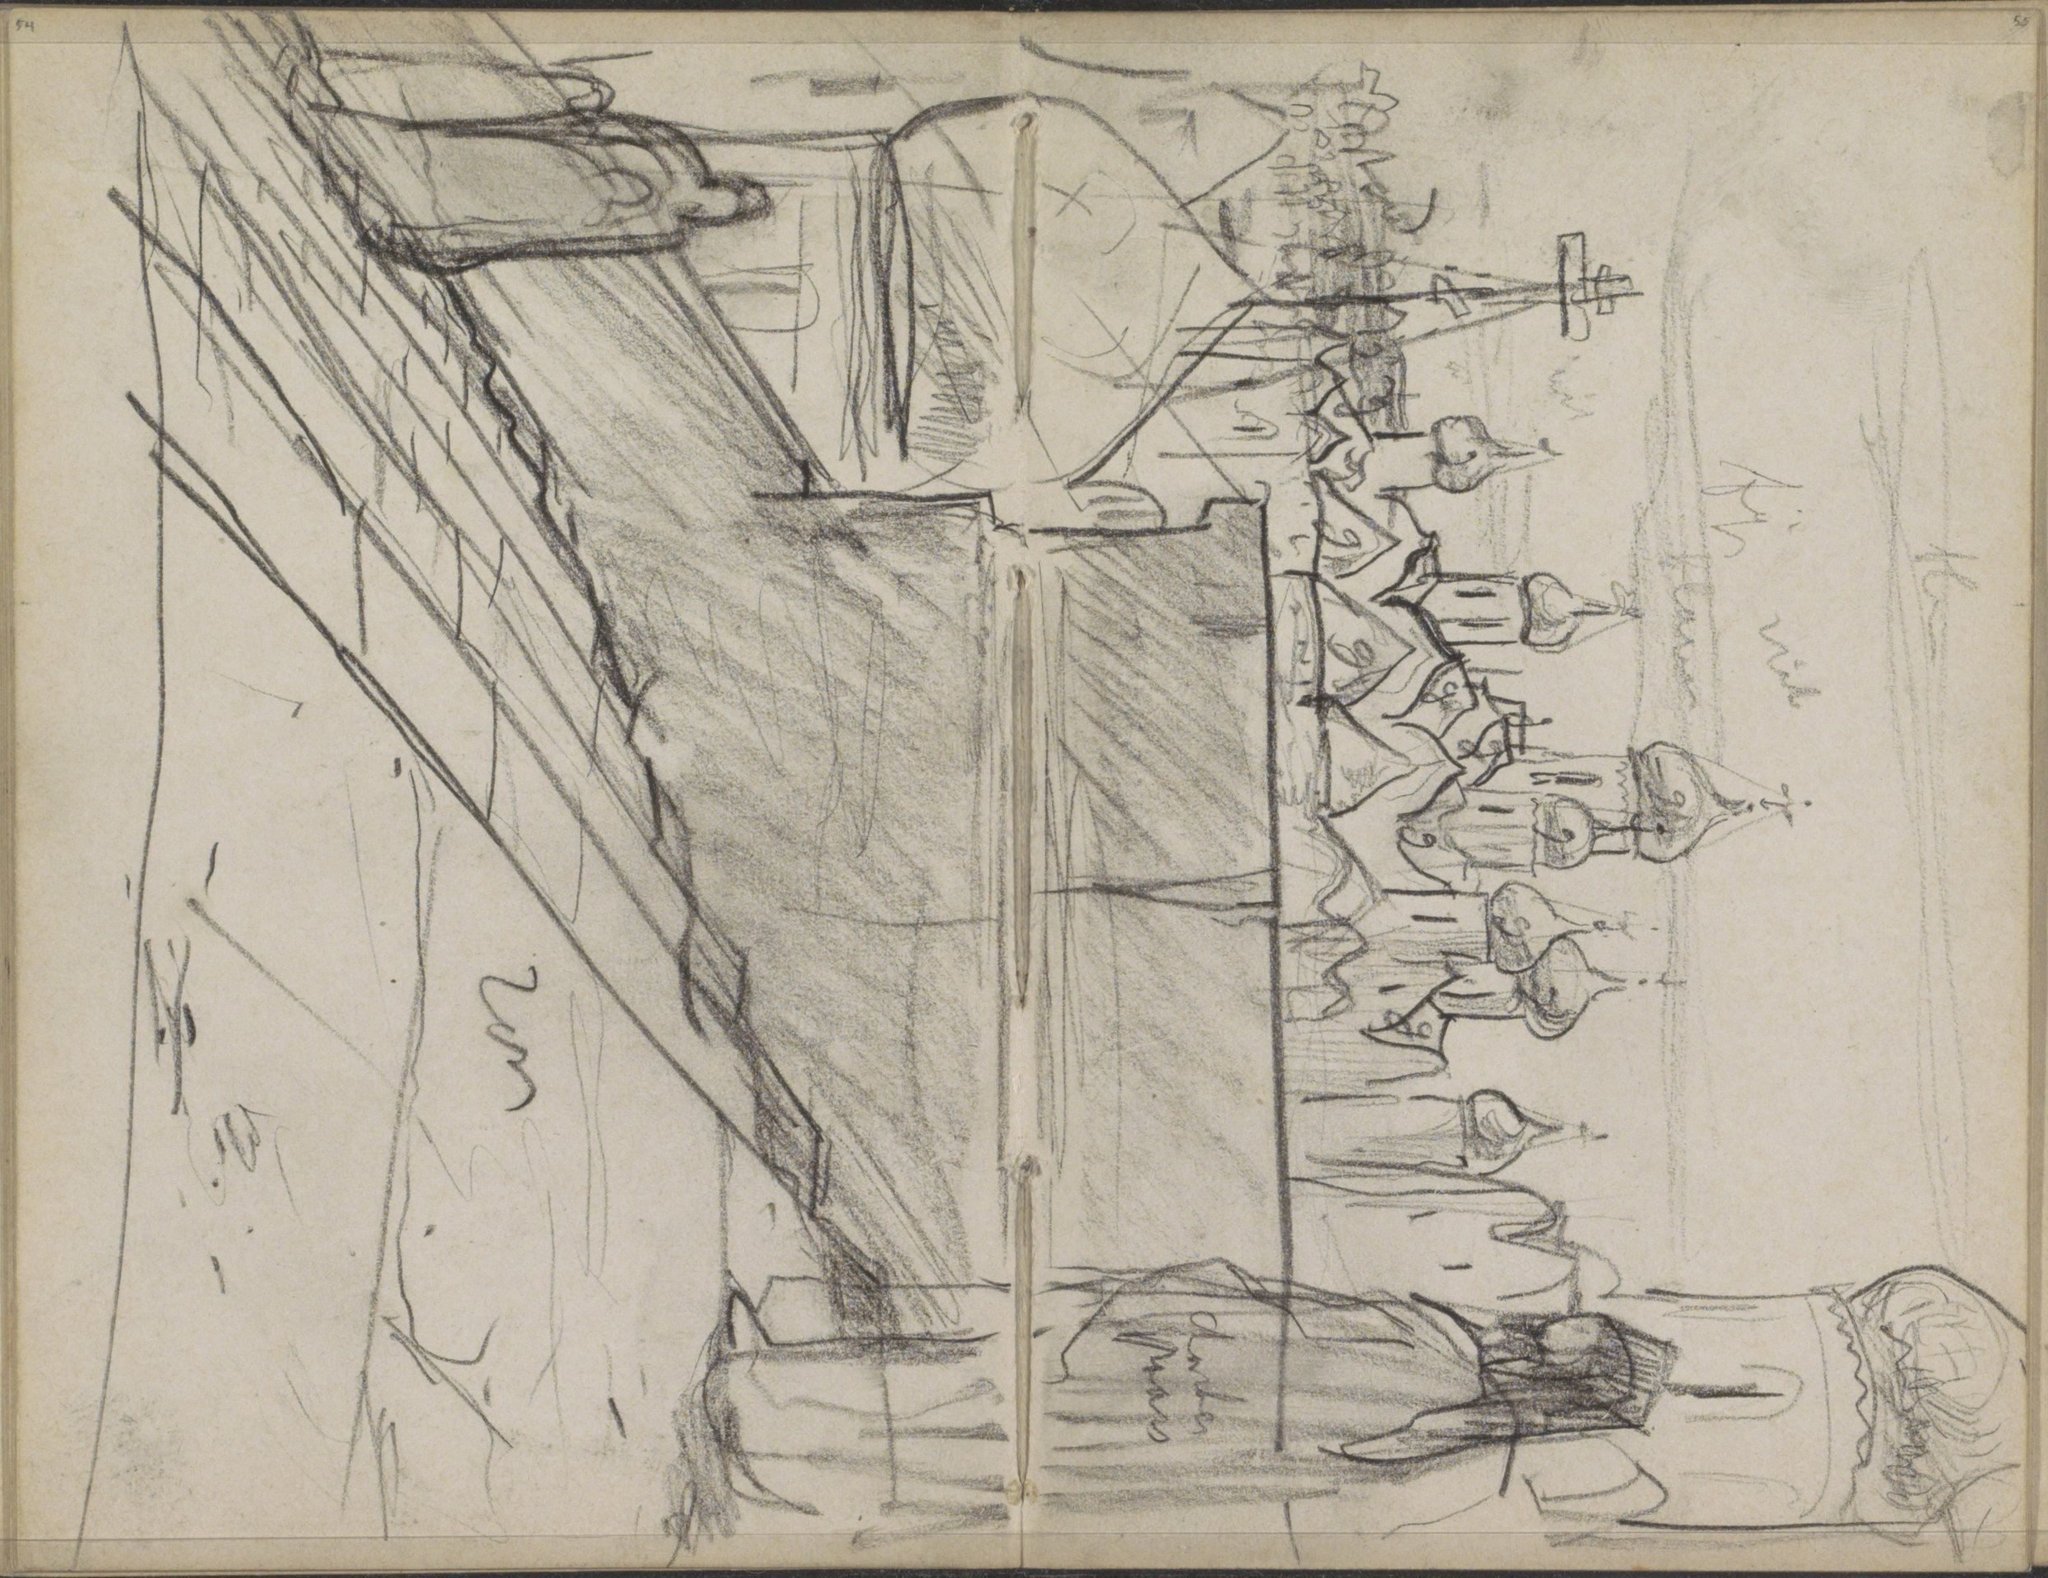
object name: sketchbook leaf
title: Trap met uitzicht op het Kremlin van Moskou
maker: marius bauer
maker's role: draughtsman, print maker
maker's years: 1867-1932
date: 1896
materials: chalk, paper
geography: moscow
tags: city-view, and landscape with man-made constructions, russian orthodox church, standing figure, flight of steps, dome ~ architecture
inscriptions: kleurnotitie, handgeschreven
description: Bauer werkte de schets uit voor een verslag van zijn reis naar Rusland voor het tijdschrift De Kroniek in 1896 (zie documentatie).